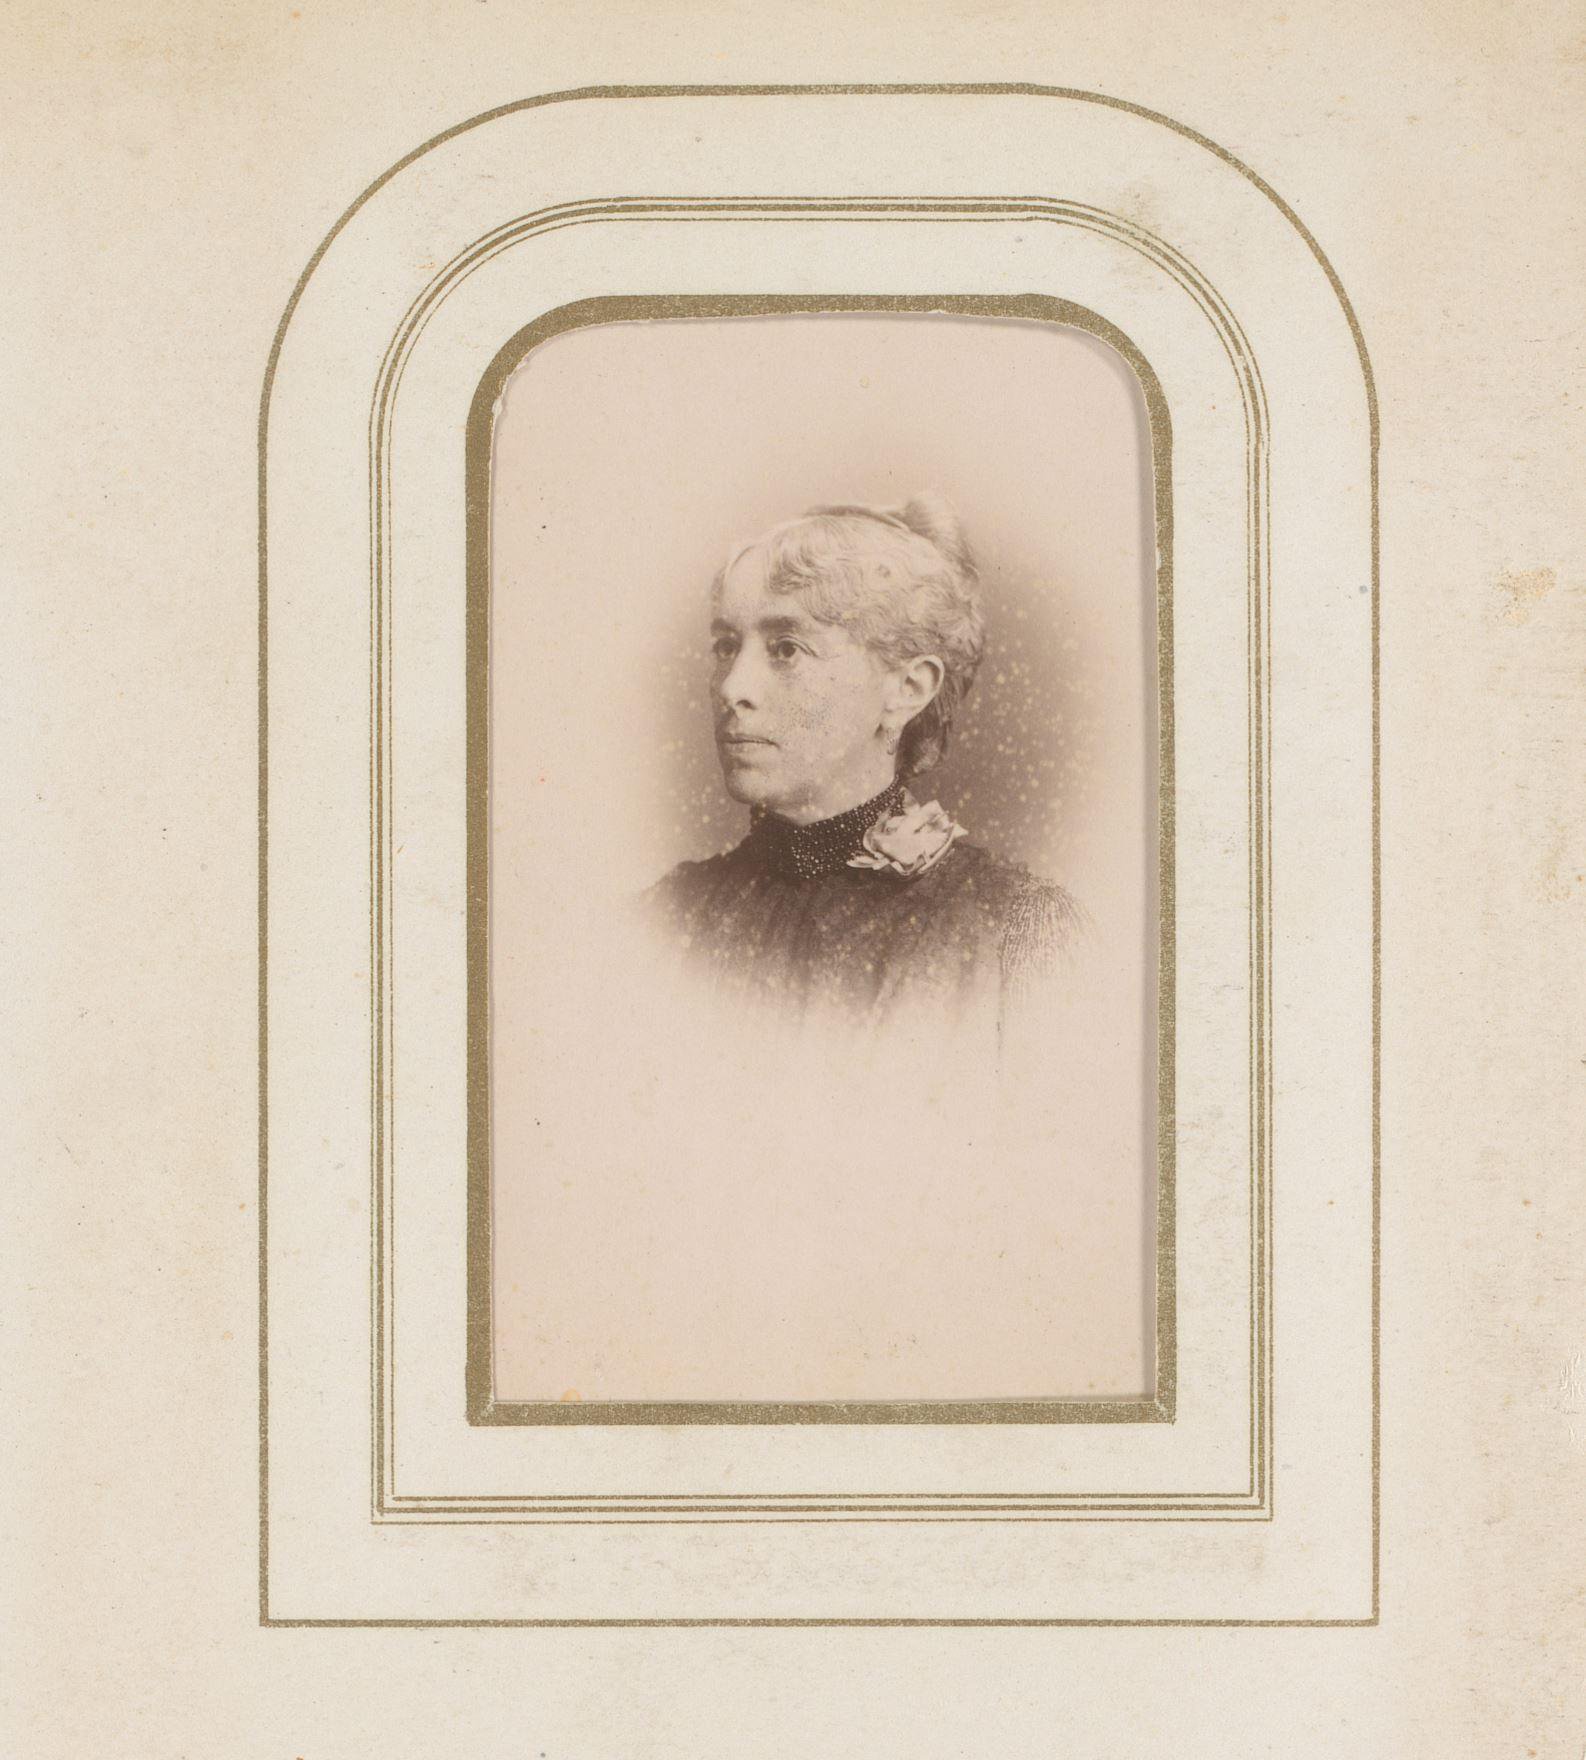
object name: photograph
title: Portret van een vrouw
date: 1860-1890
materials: cardboard, photographic support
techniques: albumen print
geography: luxembourg city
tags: historical persons - bb - woman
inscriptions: inscription: ‘Etablissement/ Photographique de/ Ch. Brandebourg fils/ Luxembourg/ Coin Avenue Amelie et Boulevard du Prince (...)’